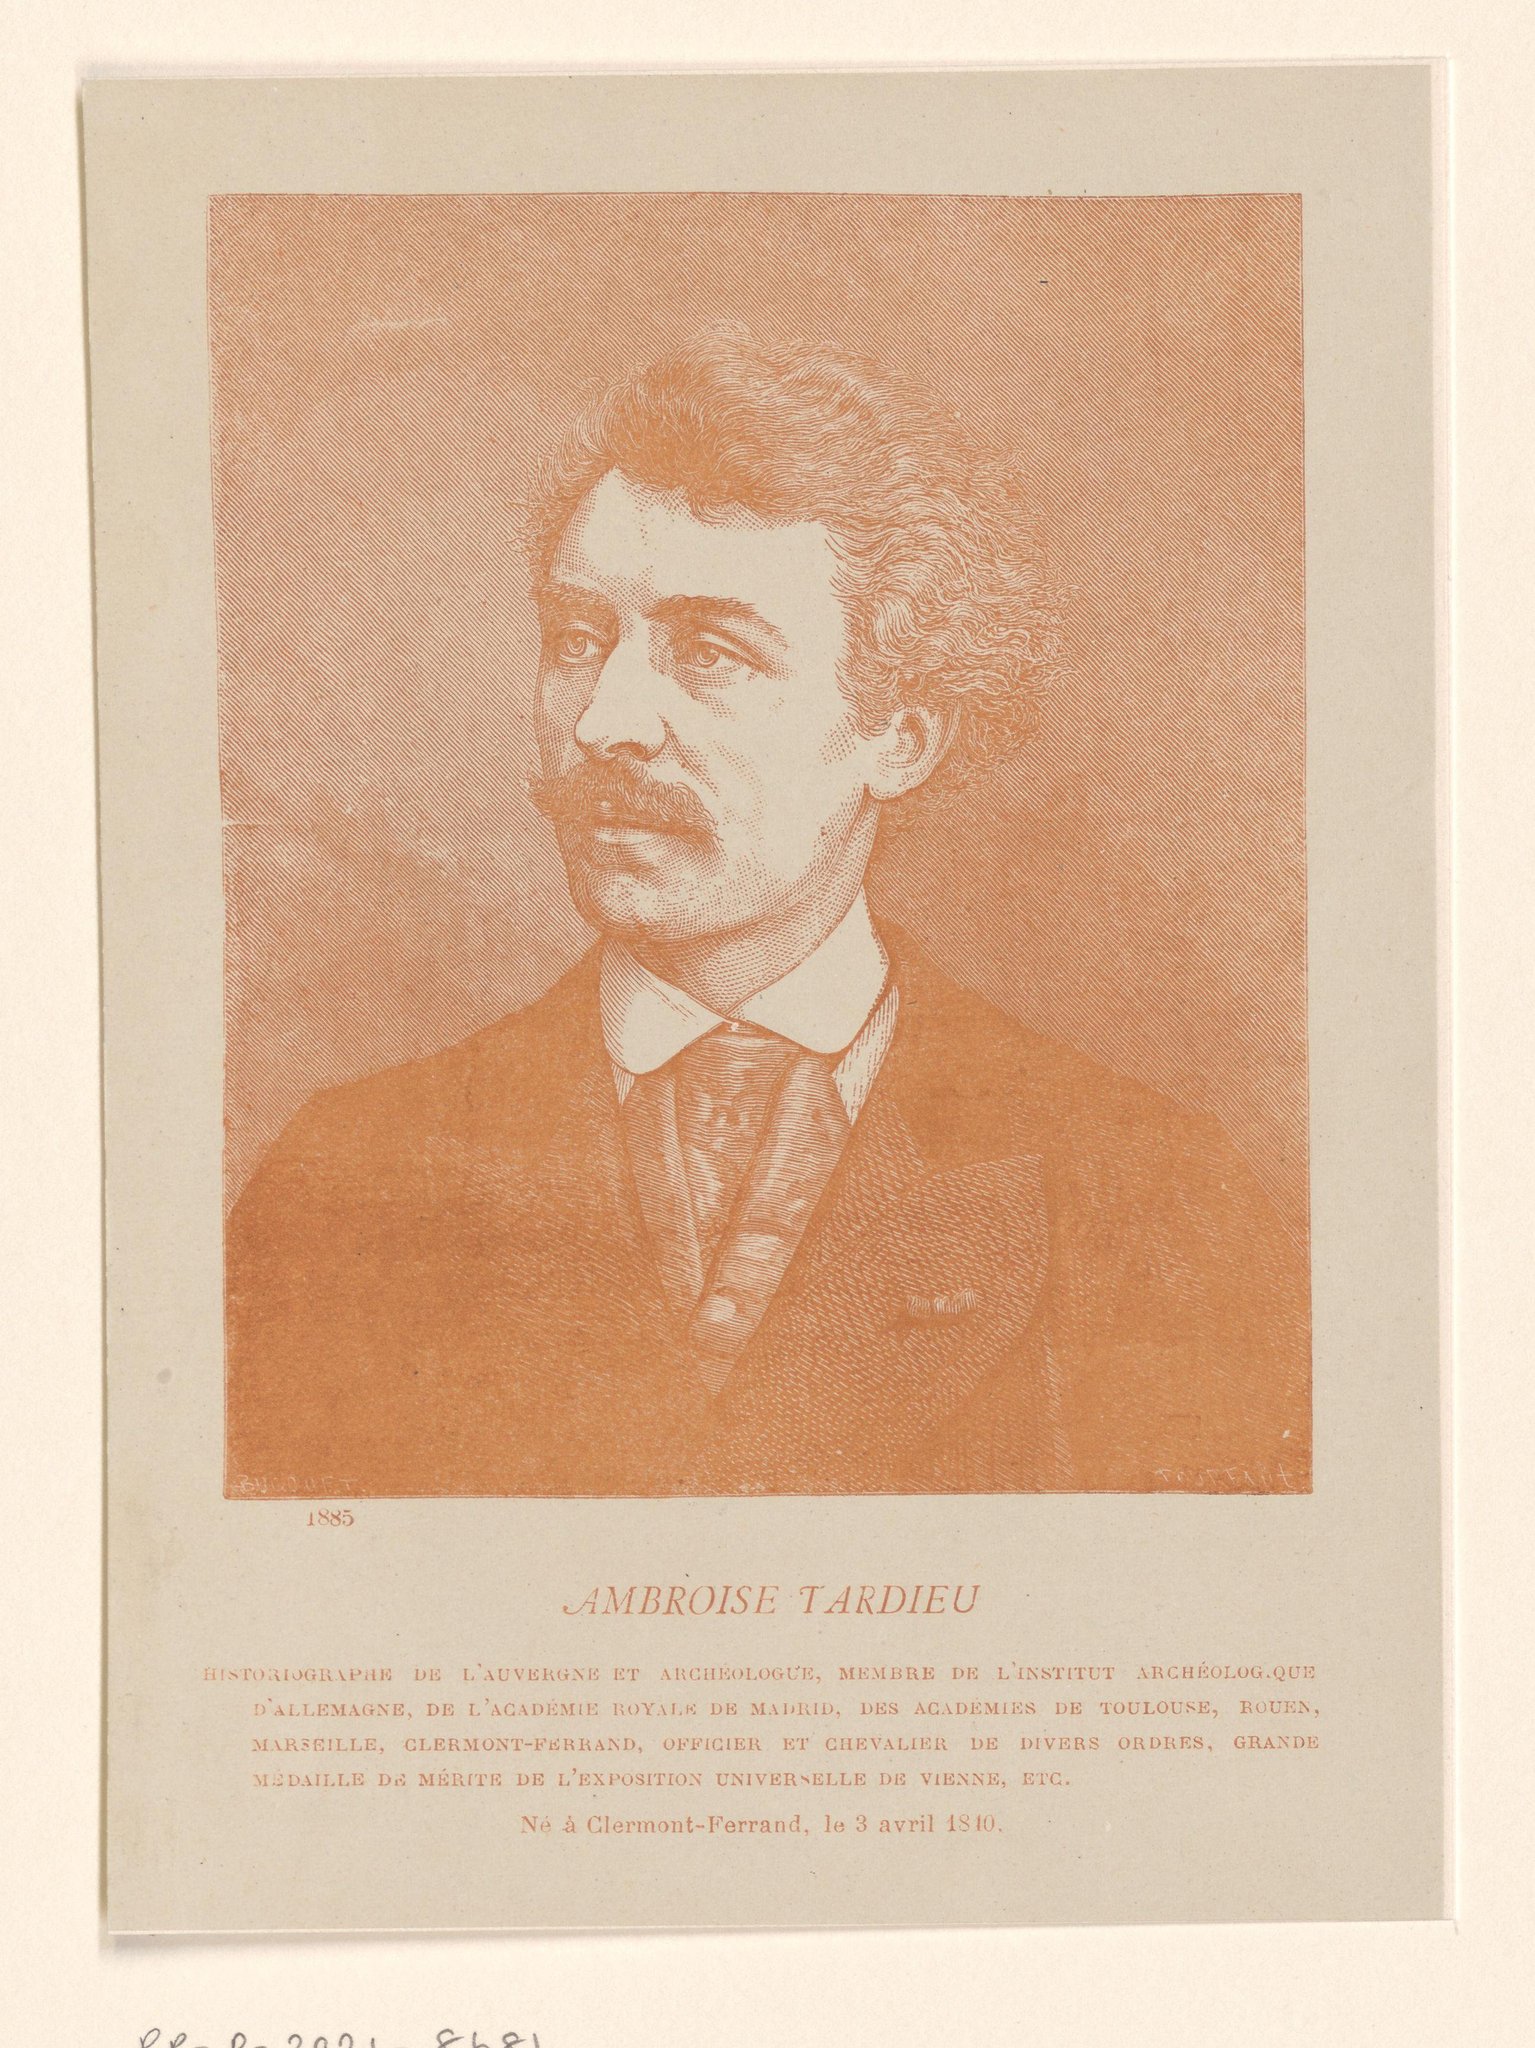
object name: print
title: Portret van Ambroise Tardieu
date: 1885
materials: paper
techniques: letterpress printing, engraving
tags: history and archaeology (+ portrait of scholar, scientist), historical persons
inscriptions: date